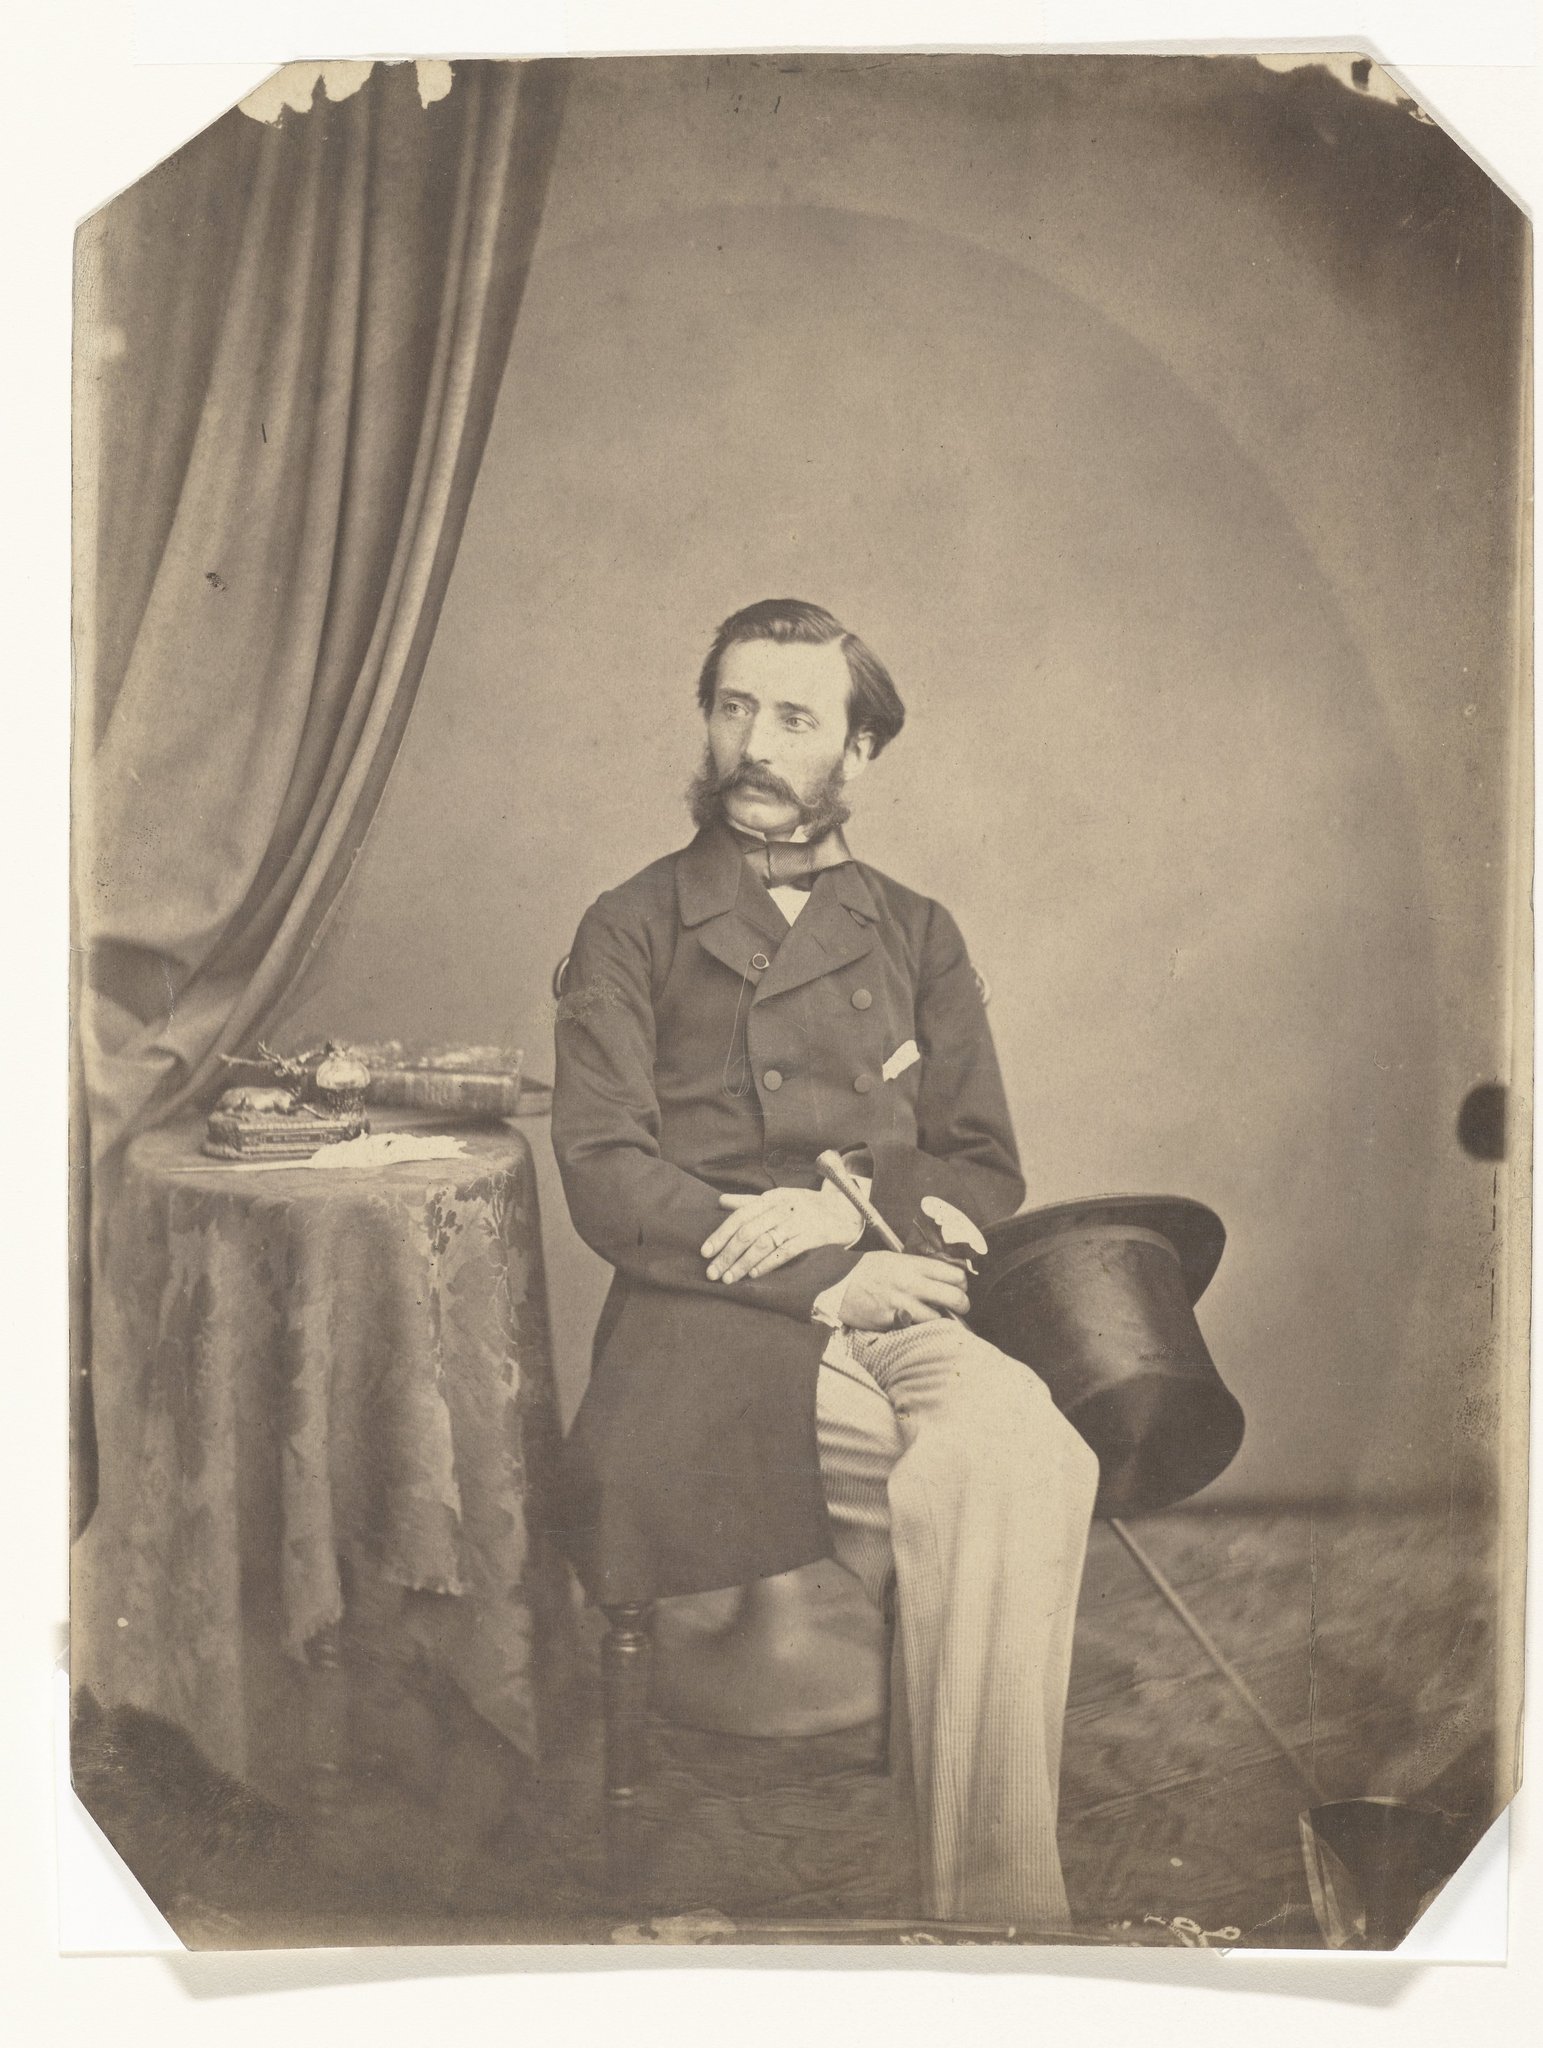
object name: photograph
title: Portret van Pieter Kornelis Koning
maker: Anonymous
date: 1855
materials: cardboard, paper, photographic support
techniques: salted paper print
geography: netherlands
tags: historical persons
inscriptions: annotation: ‘Oom Pieter Cornelis Koning N.F was directeur van het museum van Koning Willem II in de (voormalige) Gothische zaal aan het Noordeinde in Den Haag. Hij was een broer van mijn moeder en dus ook oom van de latere schrijfster Marie ...-Koning’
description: Portret van Pieter Kornelis Koning (Heenvliet 28-08-1816 - Genua 10-05-1864), rond 1840 kunsthandelaar in Rotterdam en 'inspecteur' van de verzameling moderne kunst van koning Willem II in Den Haag, tot diens overlijden in 1849